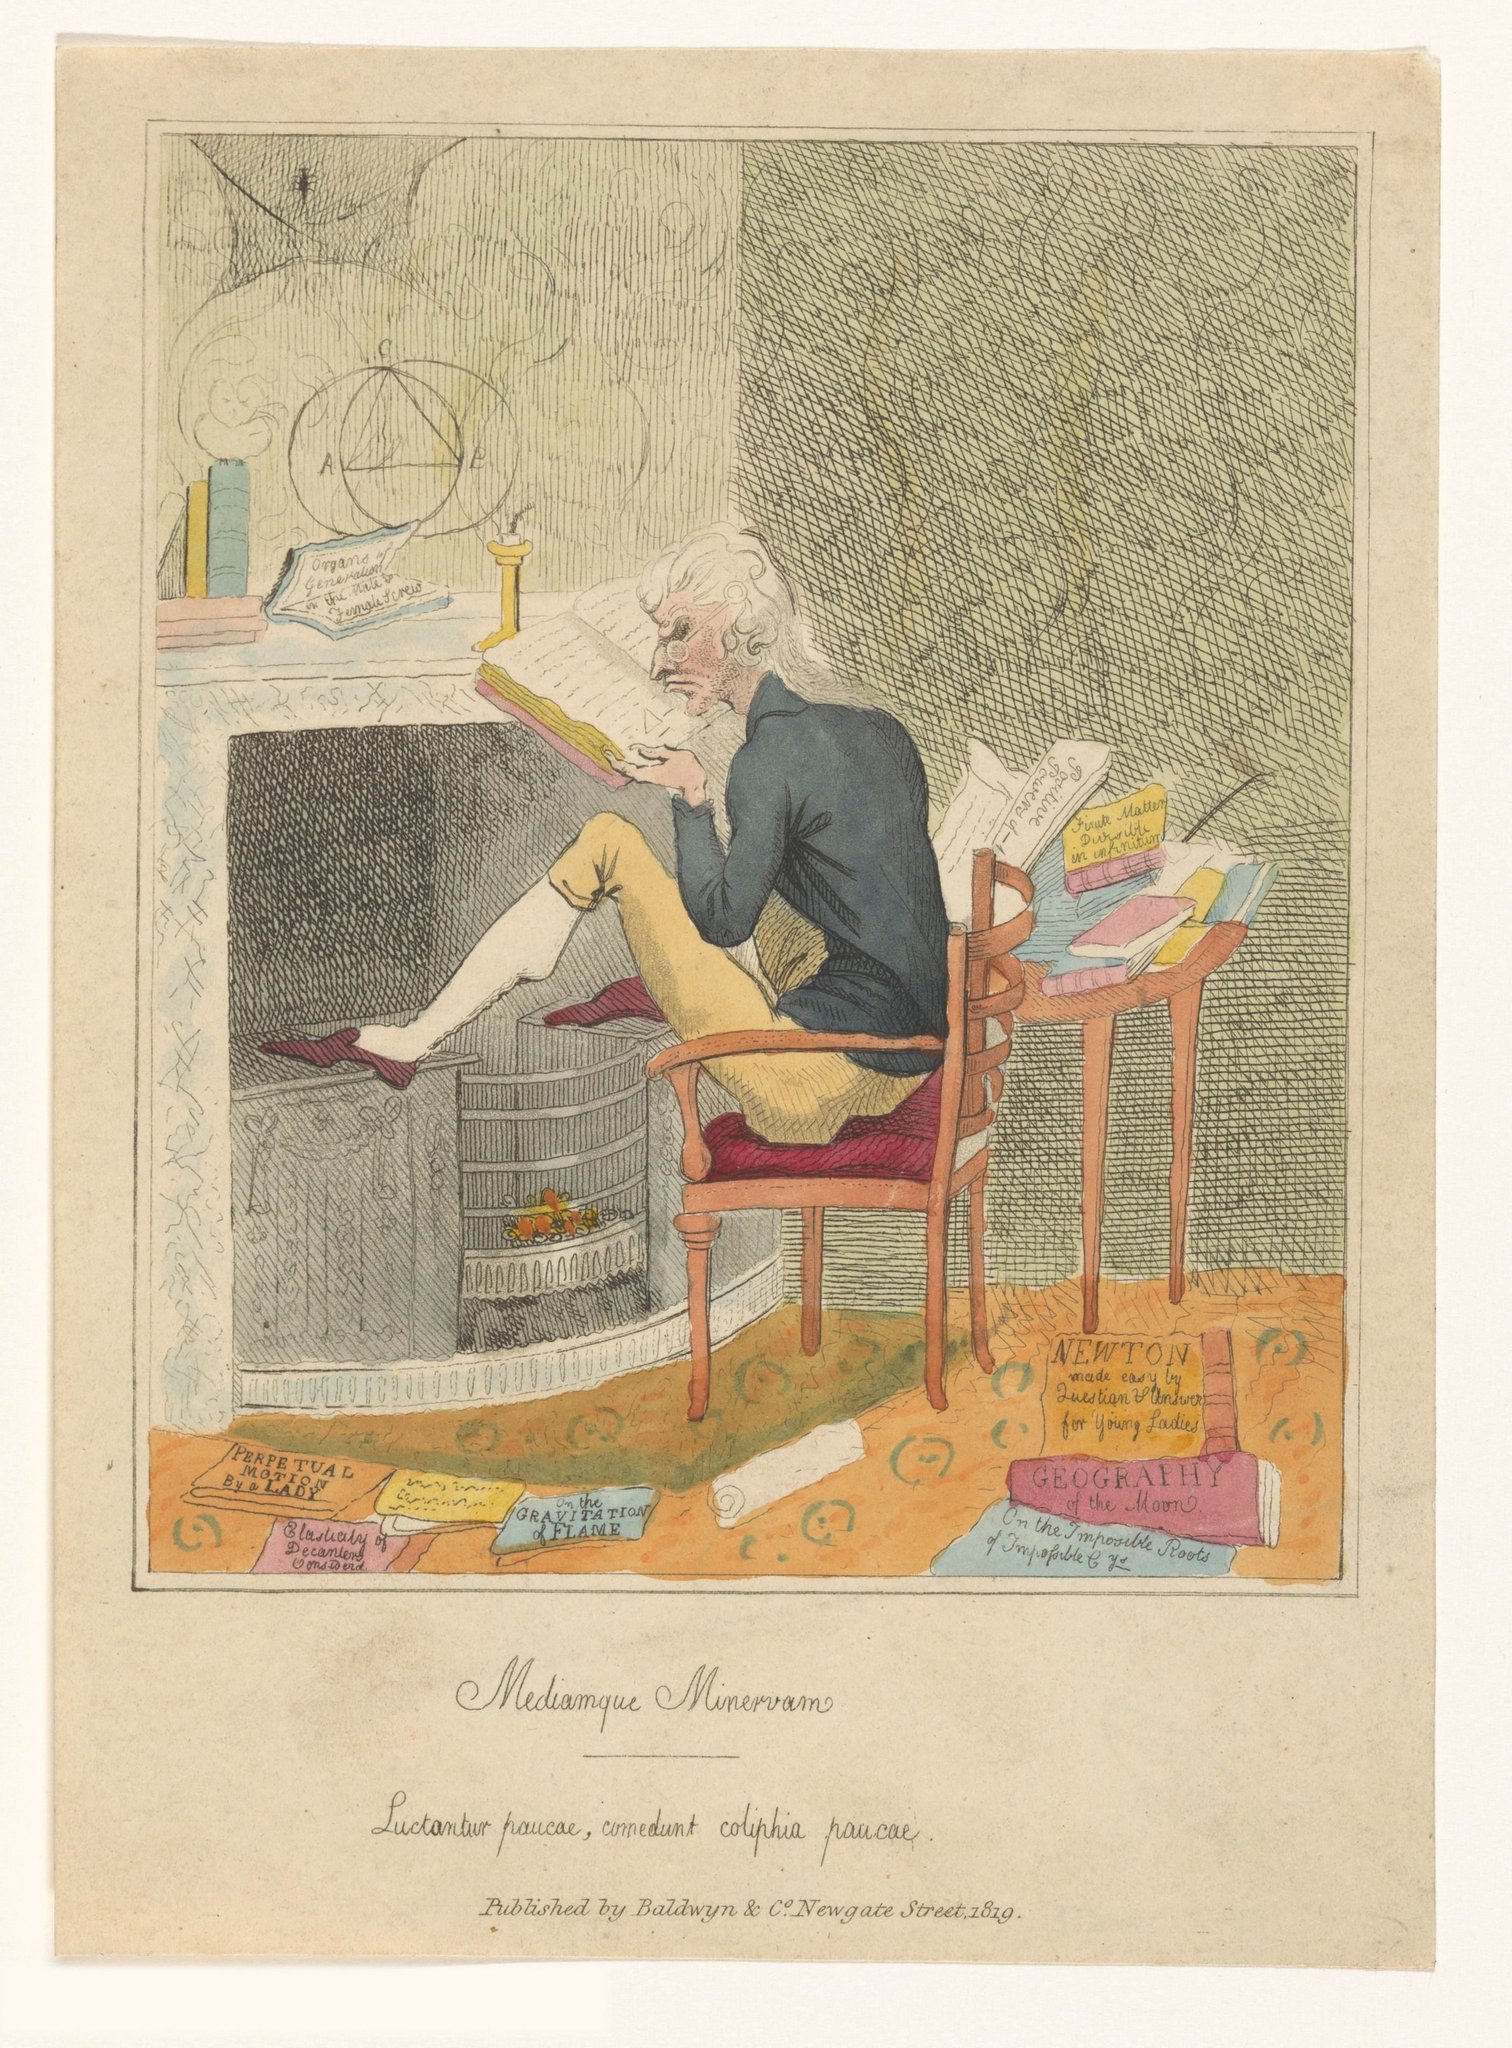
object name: print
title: Mediamque Minervam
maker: Anonymous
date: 1819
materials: paper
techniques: etching, hand coloring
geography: london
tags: caricatures (human types), study; 'studiolo'; library, book, newspaper, news-sheet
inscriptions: collector's mark: Lugt 2228, collector's mark: Lugt 4779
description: De onderschriften in het Latijn zijn afkomstig uit de satiren van Juvenalis. Waarschijnlijk wordt op deze prent de spot gedreven met de pretenties van deze geleerde. Zo leest een van de titels: "Newton made easy by Question & Answer for Young Ladies".